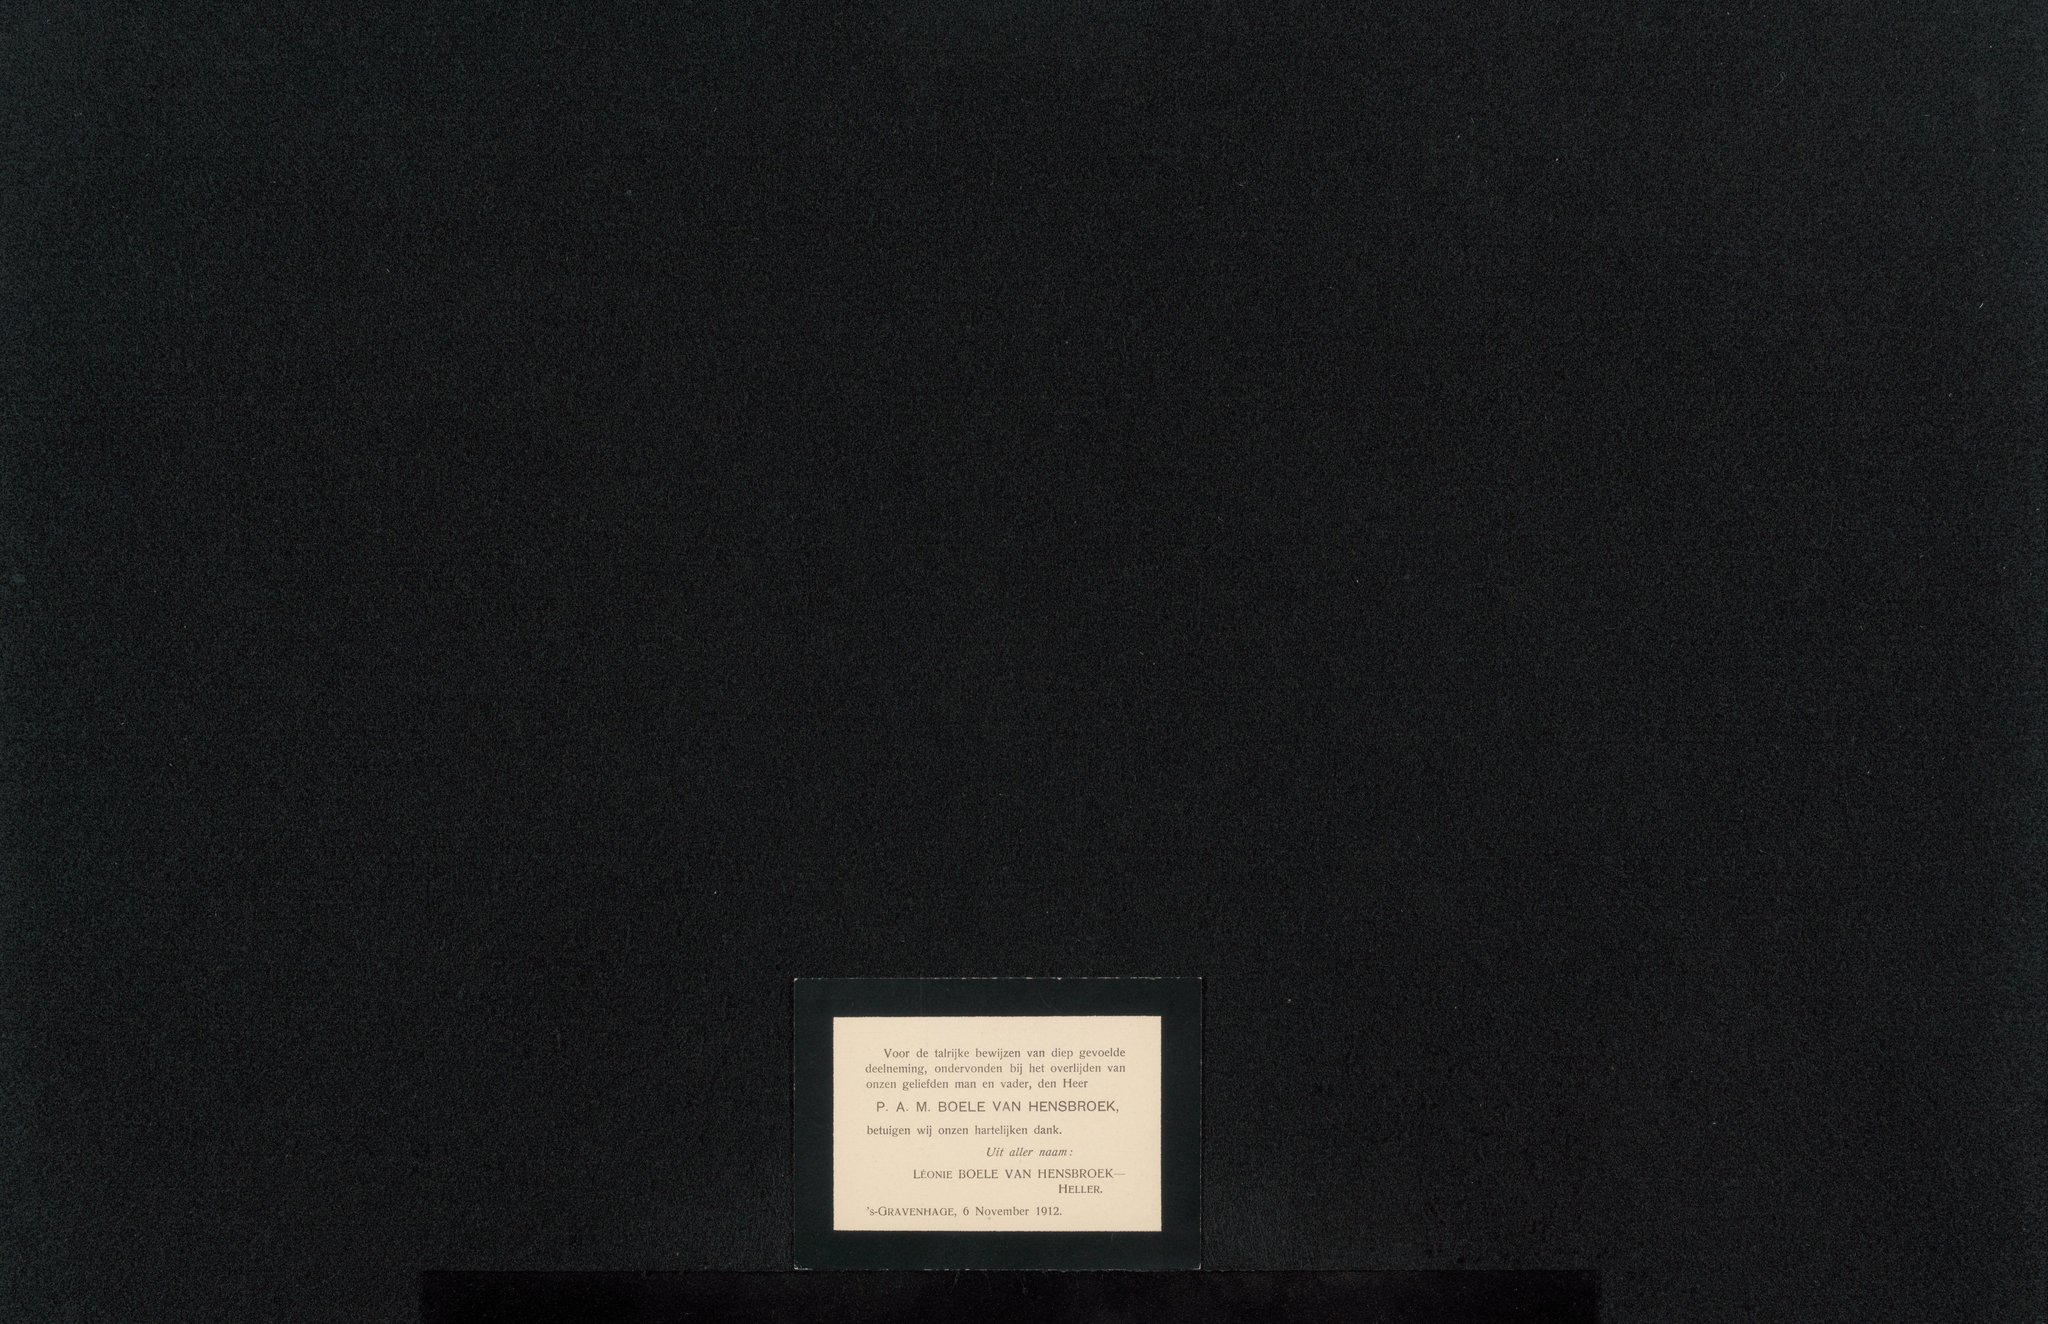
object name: letter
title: Brief aan Philip Zilcken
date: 1912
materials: cardboard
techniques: printing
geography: the hague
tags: publisher, pieter andreas martin boele van hensbroek, painter, draughtsman, philip zilcken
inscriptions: collector's mark: ‘RPK’